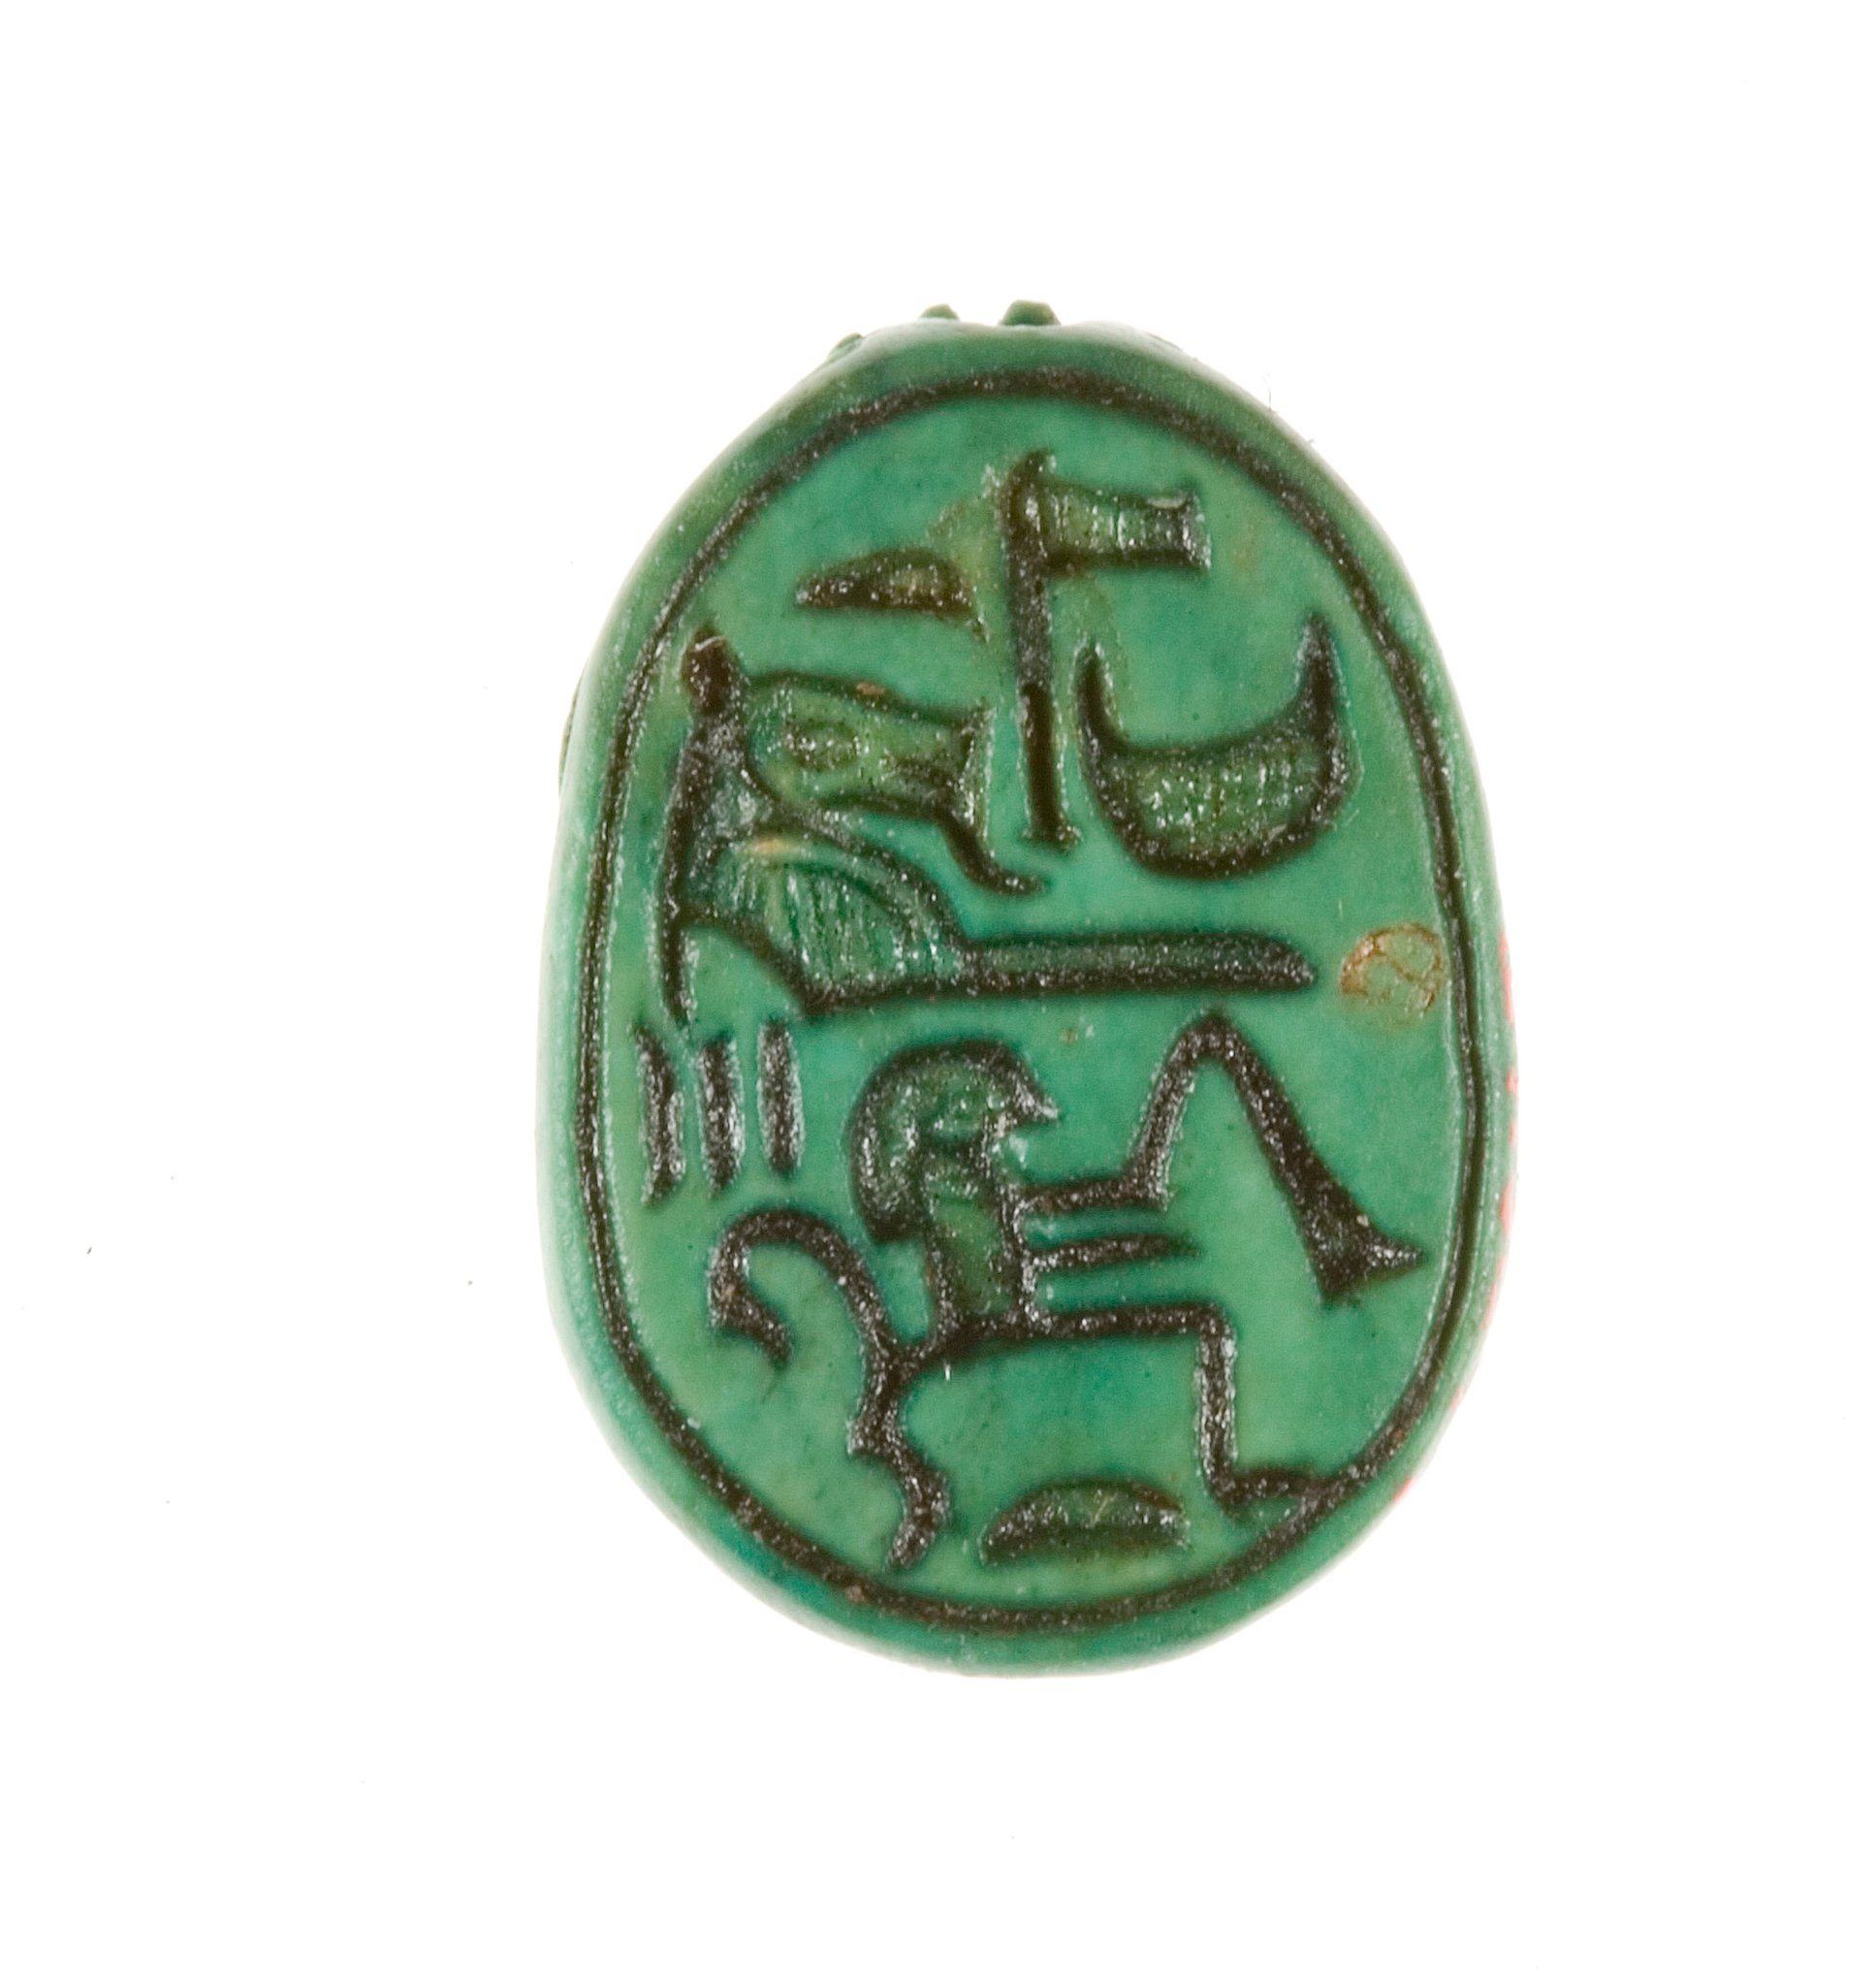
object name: scarab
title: Scarab Inscribed for the God's Wife Hatshepsut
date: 1479-1458 BCE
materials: stone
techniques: glazing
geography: egypt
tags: hieroglyphs,scarabs